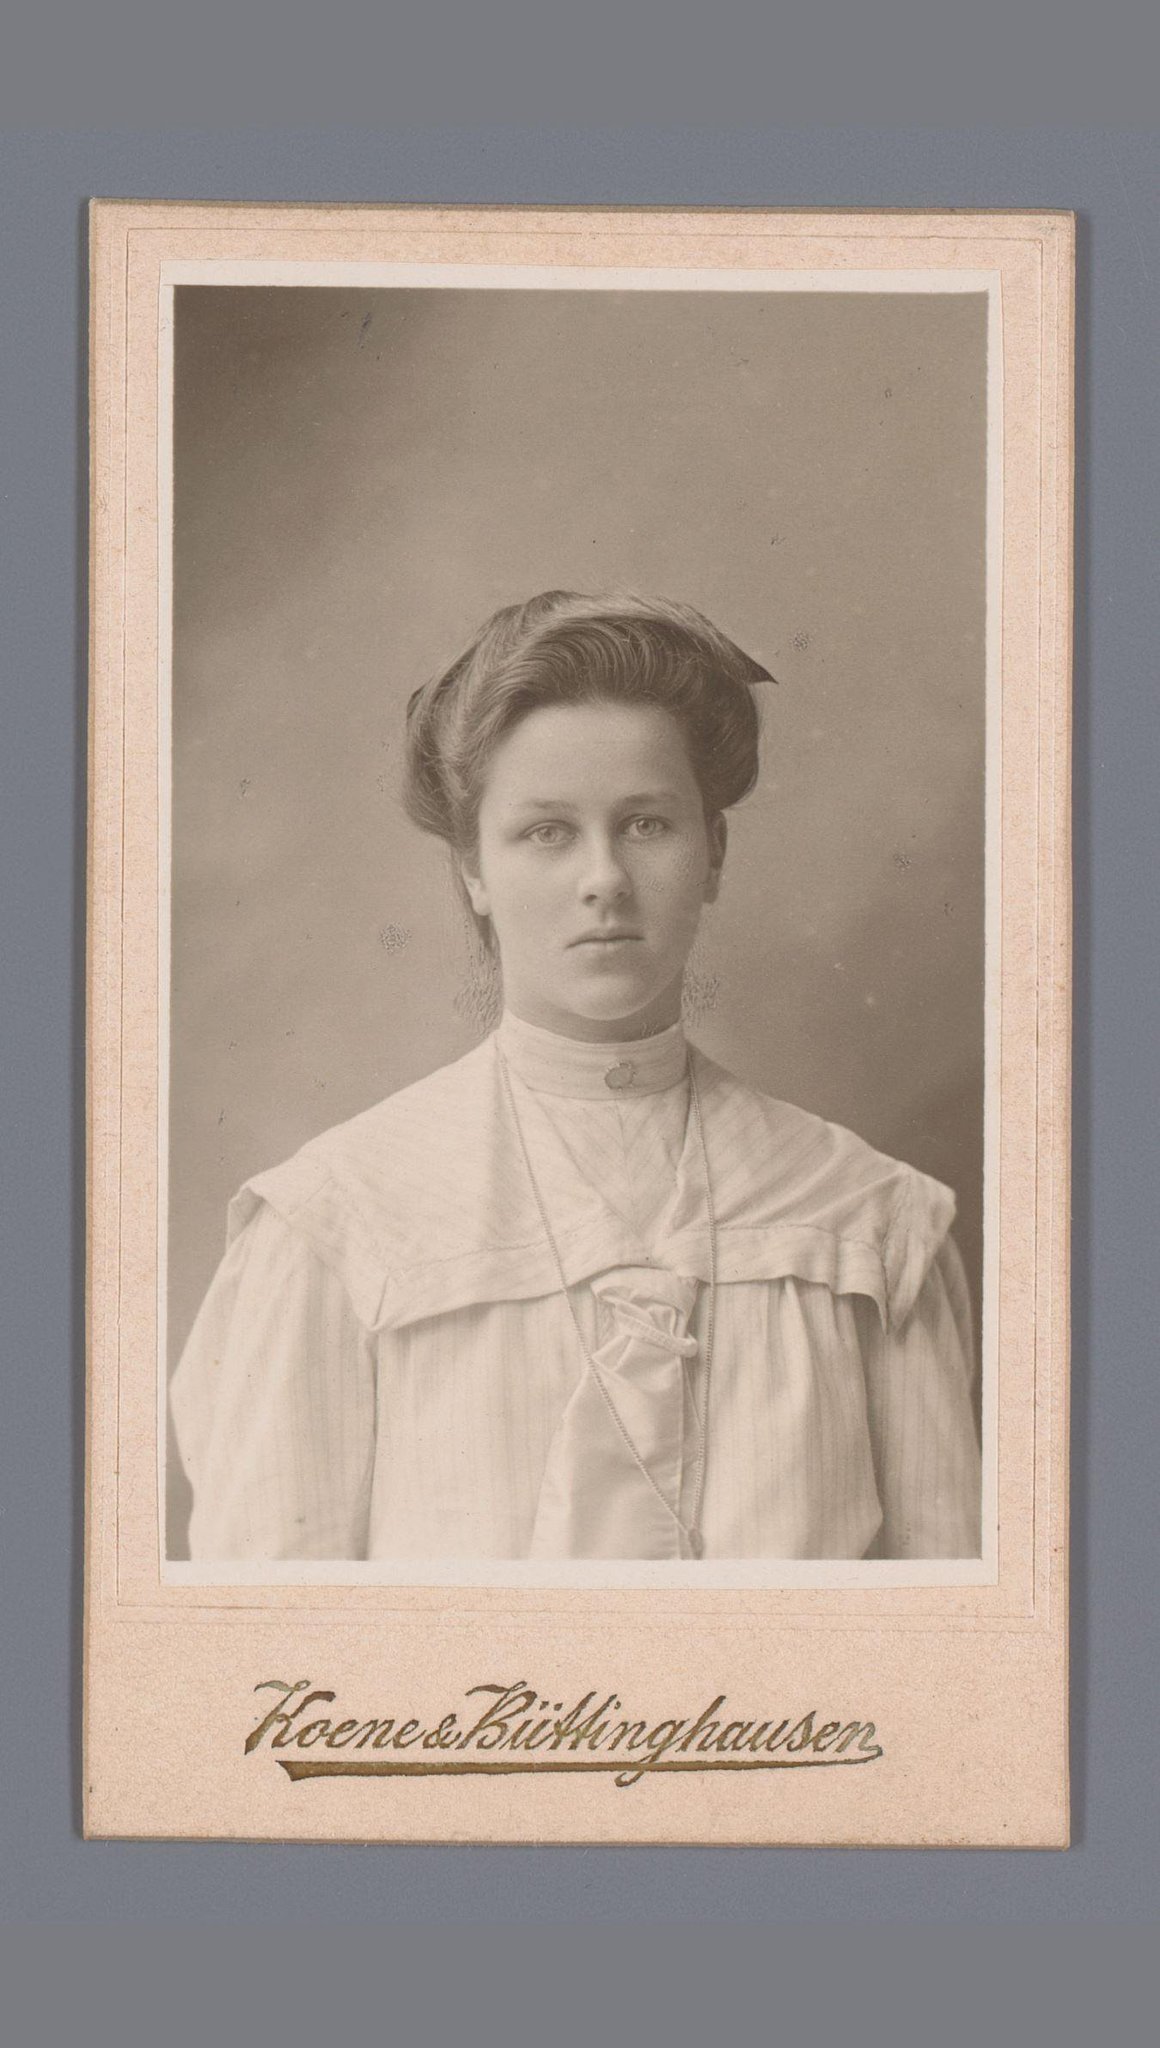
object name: carte de visite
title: Portret van Johanna Geertruida Jonker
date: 1905-1910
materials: cardboard, photographic support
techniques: gelatin silver print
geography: amsterdam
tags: historical persons, amsterdam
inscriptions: workshop stamp: ‘Koene&Büttinghausen/ Amsterdam Heerengracht 150, Telephoonnummer 1402/ Batavia’